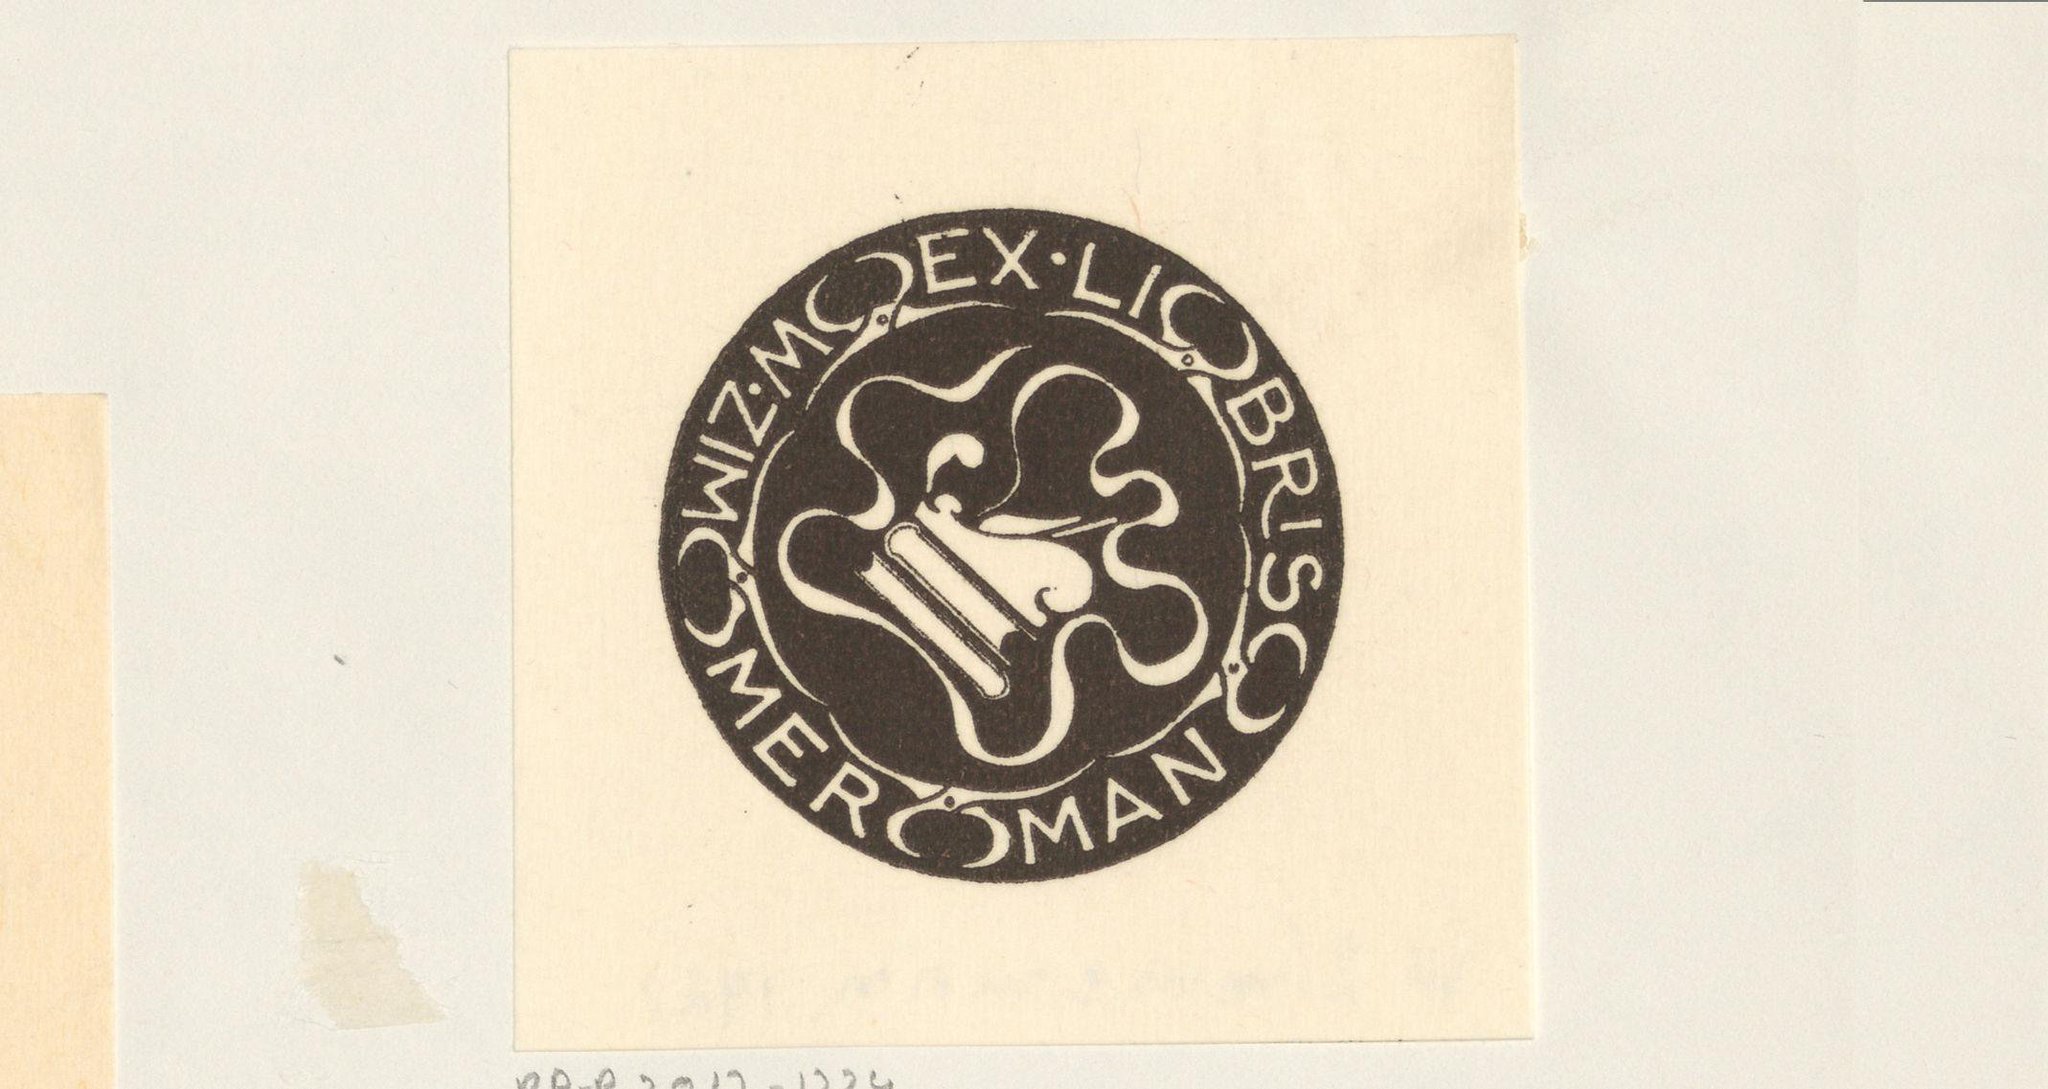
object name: bookplate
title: Ex libris van W. Zimmerman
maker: Anonymous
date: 1927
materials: paper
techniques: printing block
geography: netherlands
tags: print maker, willem zimmerman, tools, aids, implements ~ crafts and industries: tongs, tools, aids, implements ~ crafts and industries: plane, book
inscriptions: date